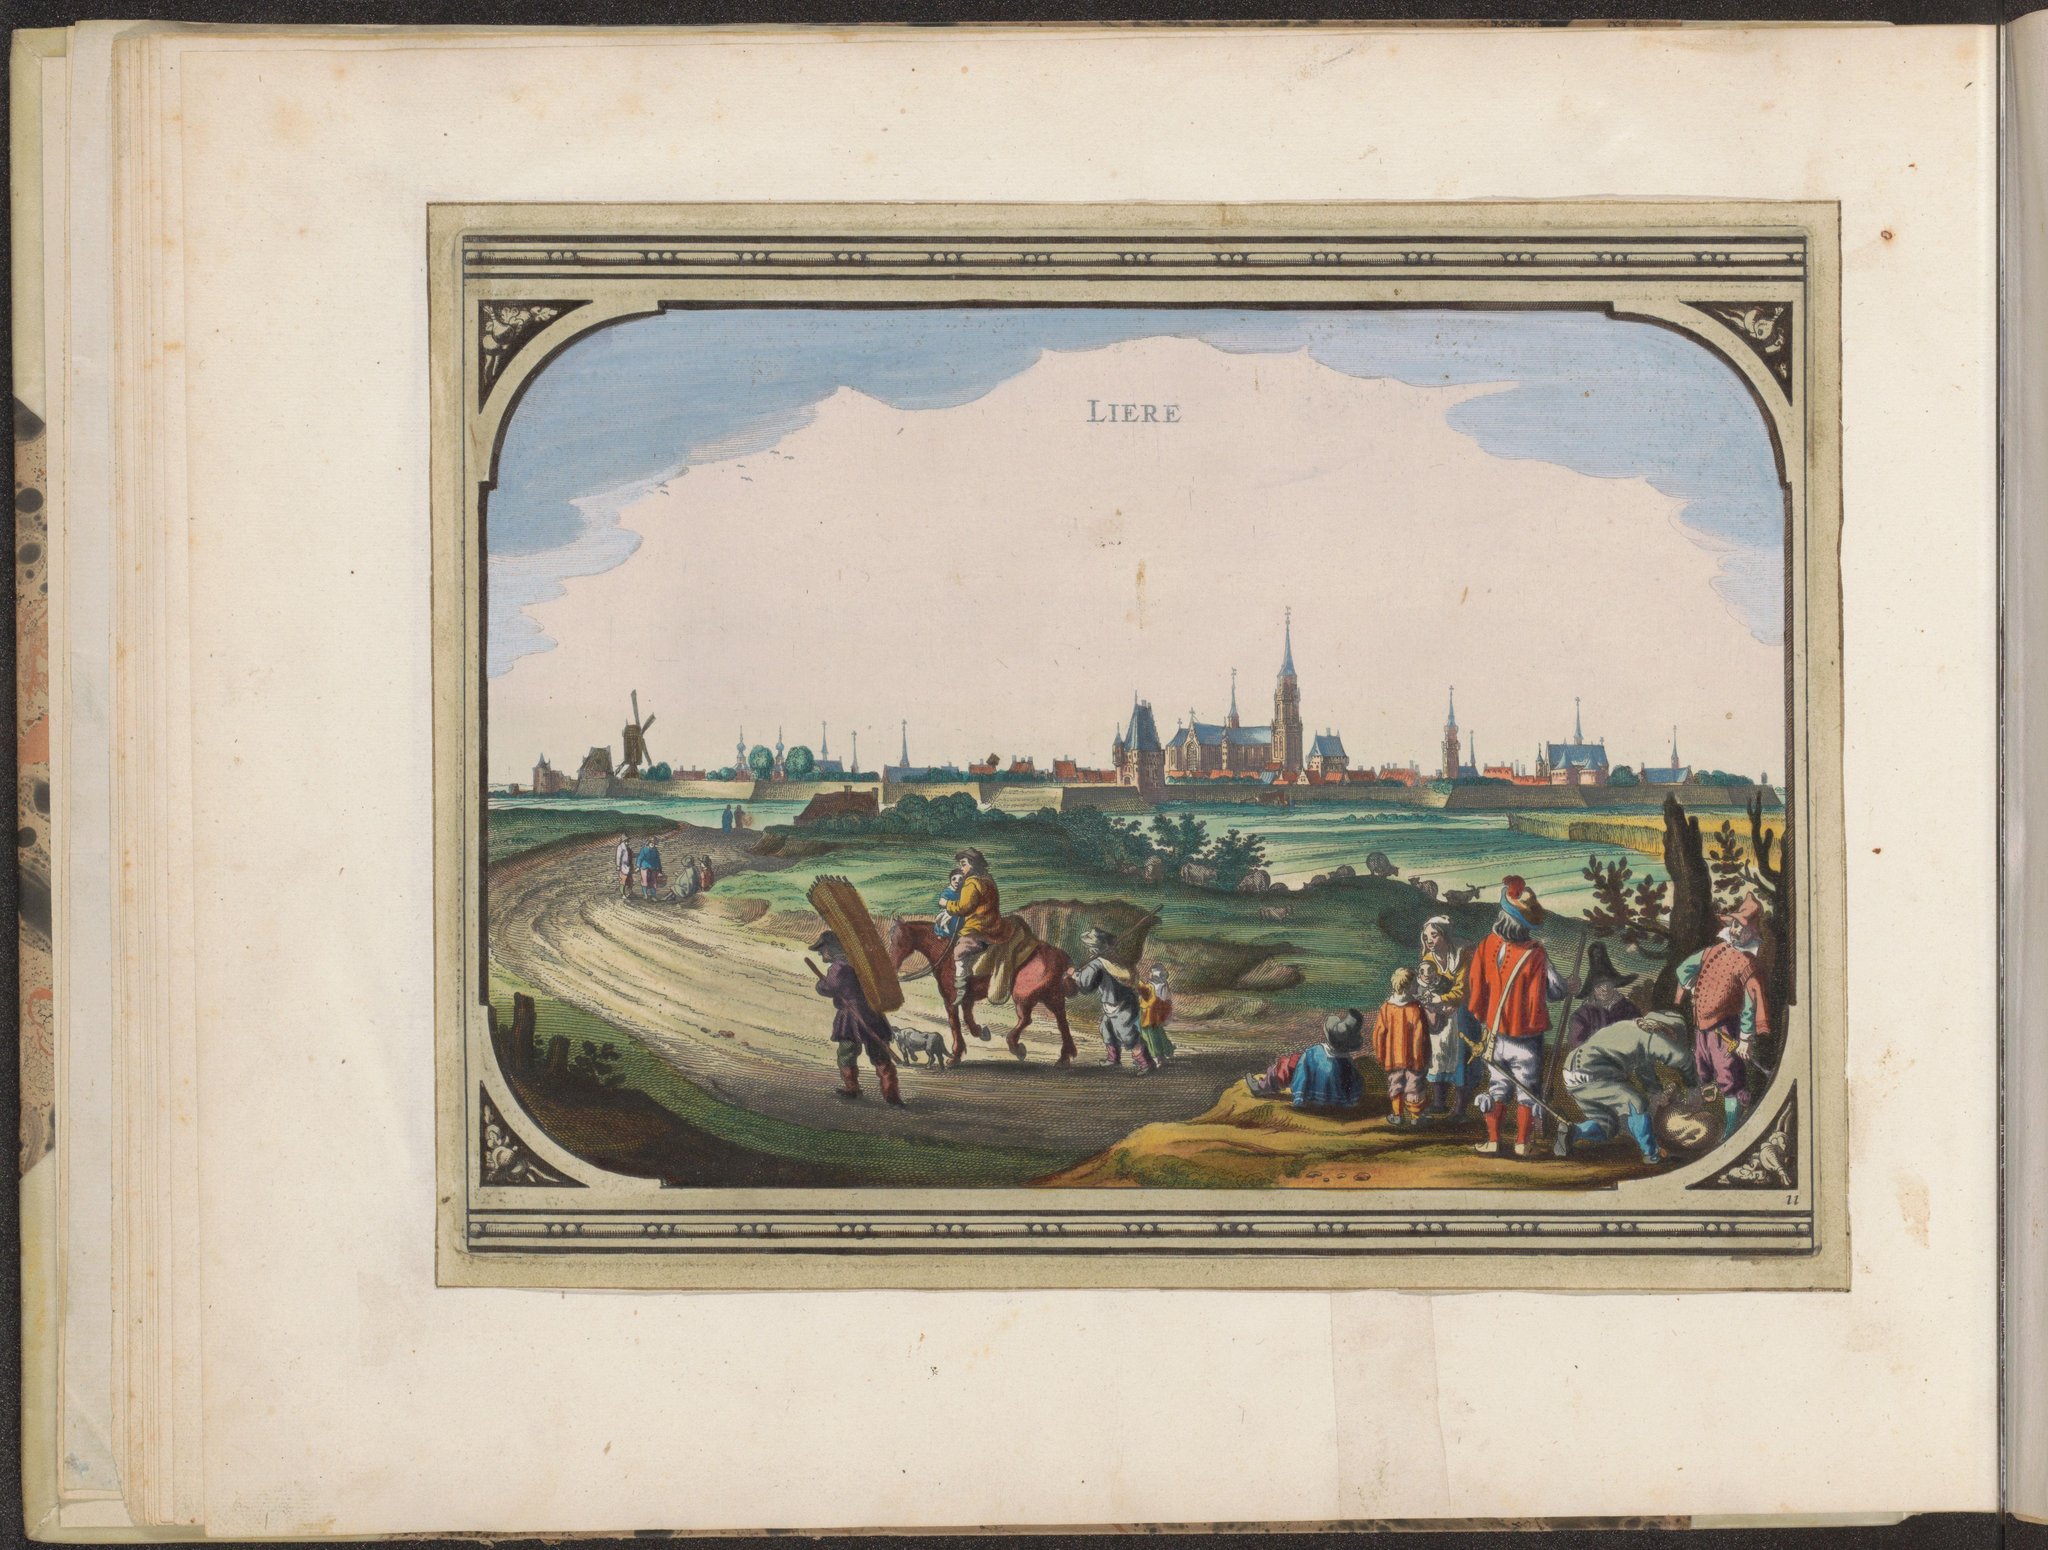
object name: album leaf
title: Liere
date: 1657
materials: paper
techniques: etching, hand coloring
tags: city-view, and landscape with man-made constructions, (traveller) resting in the open air, 'en route', traveller under way, lierre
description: Gezicht op de stad Lier met reizigers op een weg. De prent maakt deel uit van een album.